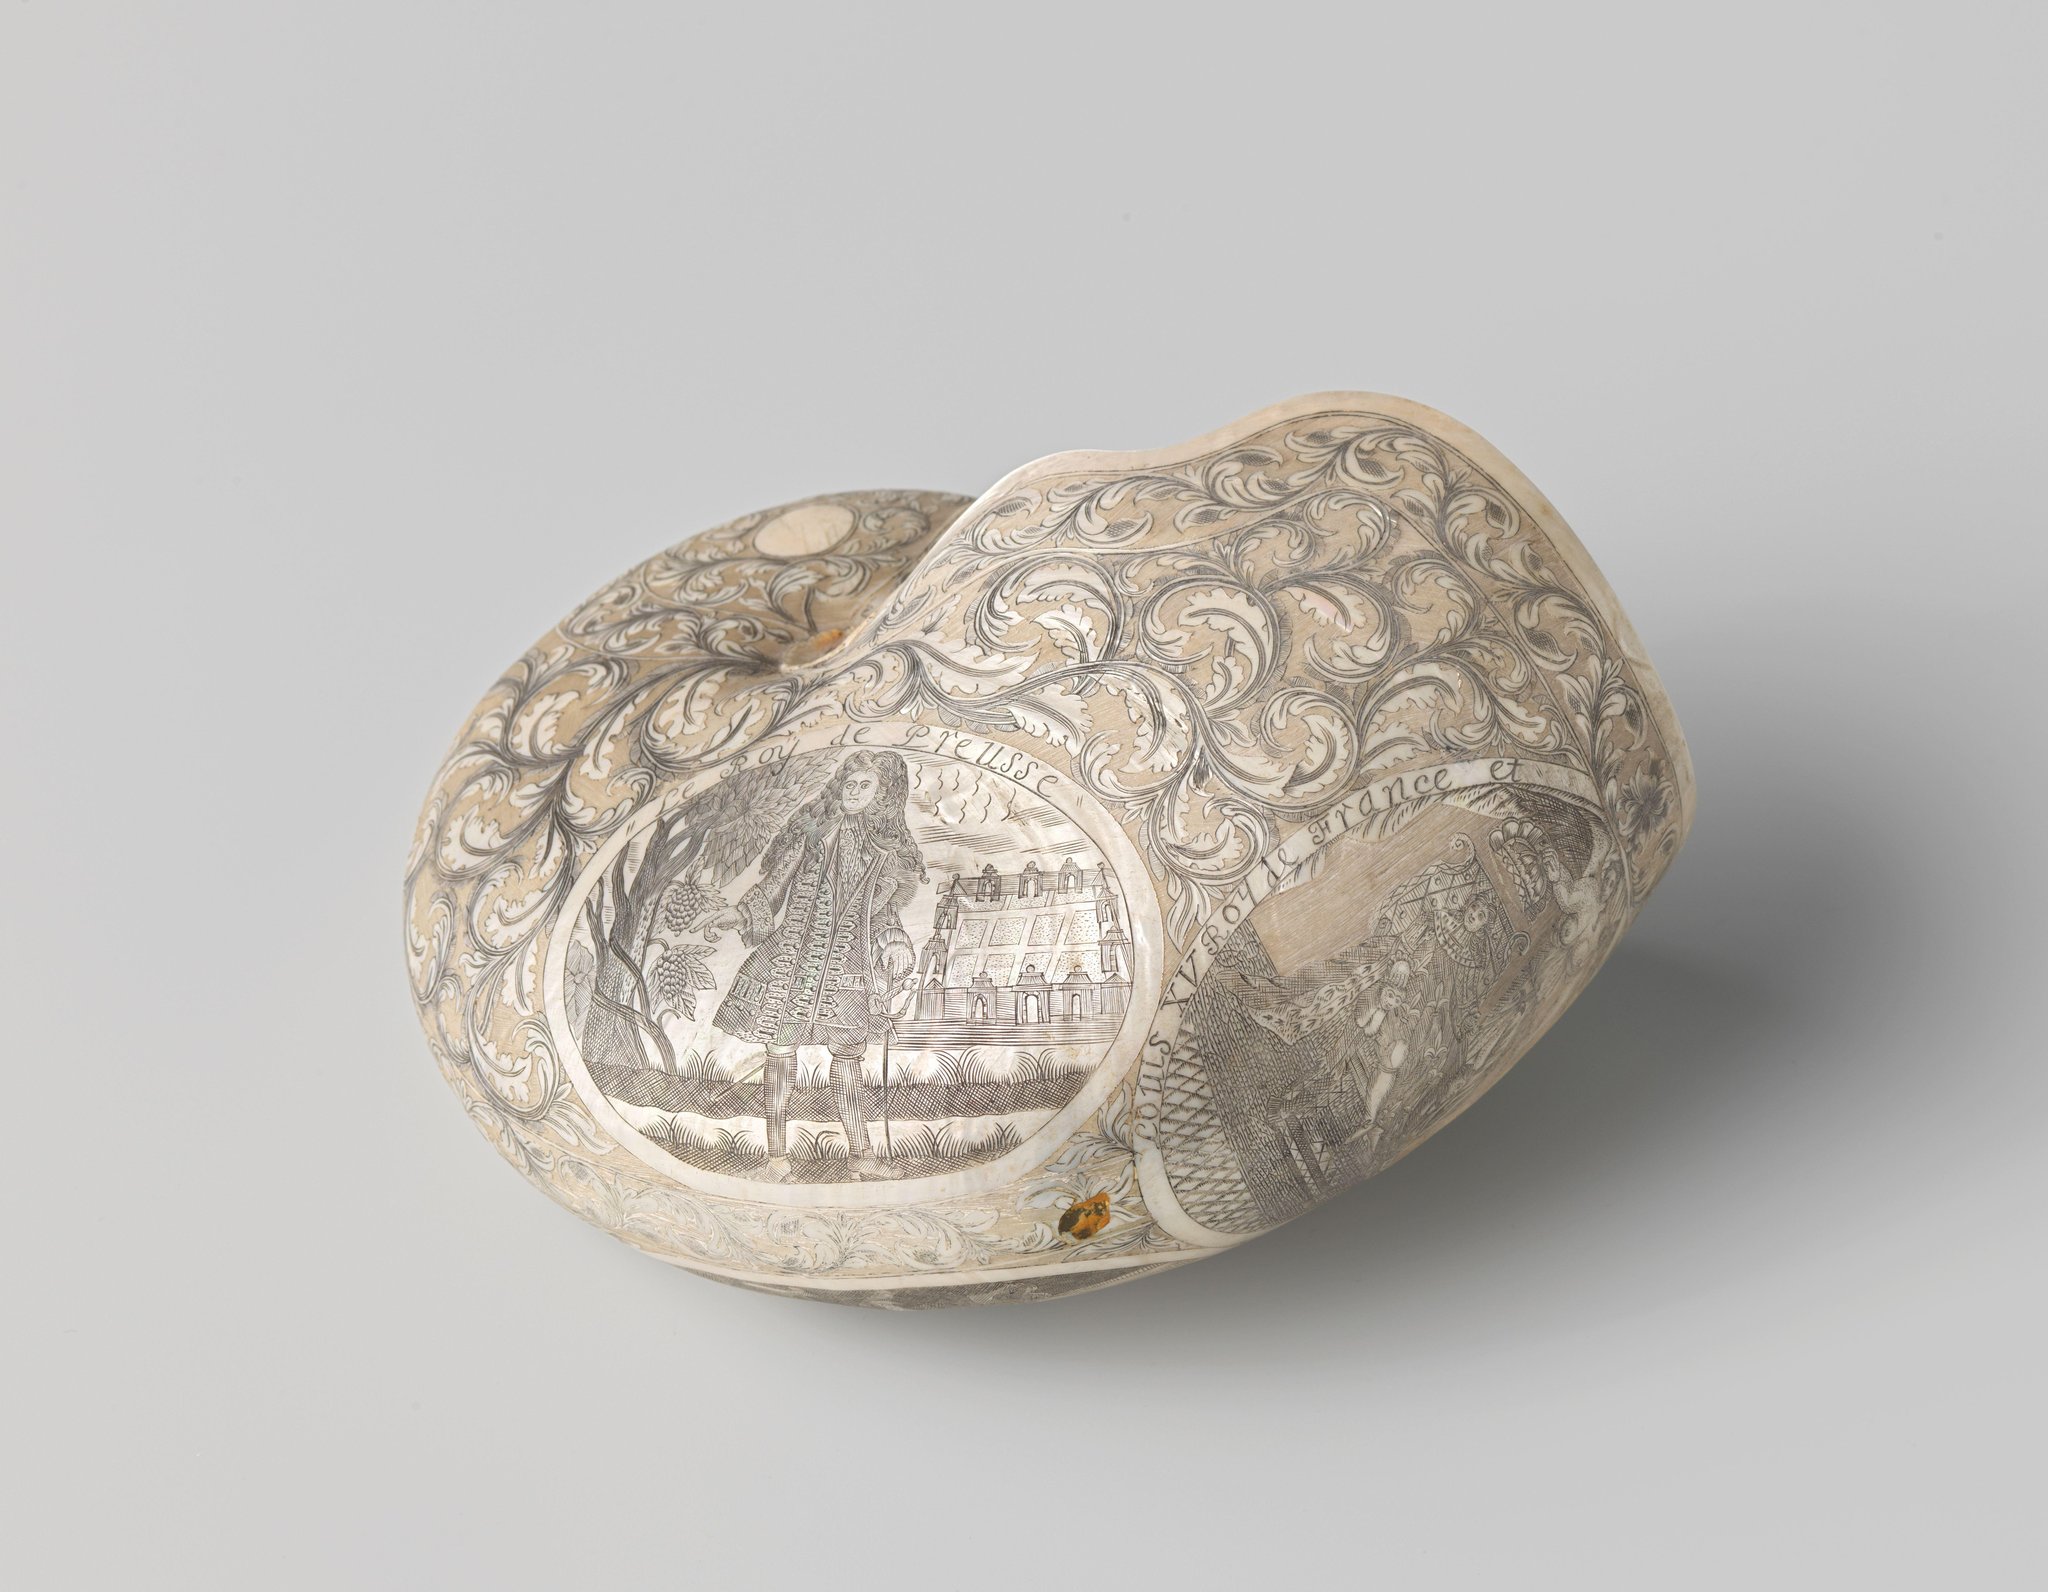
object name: nautilus shell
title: Nautilus met drie medaillons met gesneden versieringen, resp. Louis XV; Le roy de Angleterre; Le roy de Prusse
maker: Anonymous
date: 1675-1700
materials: mother of pearl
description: Een nautilus waarop in drie medaillons gesneden: (1) Louis XV (2) Le roy de Angleterre (3) Le roy de Prusse.